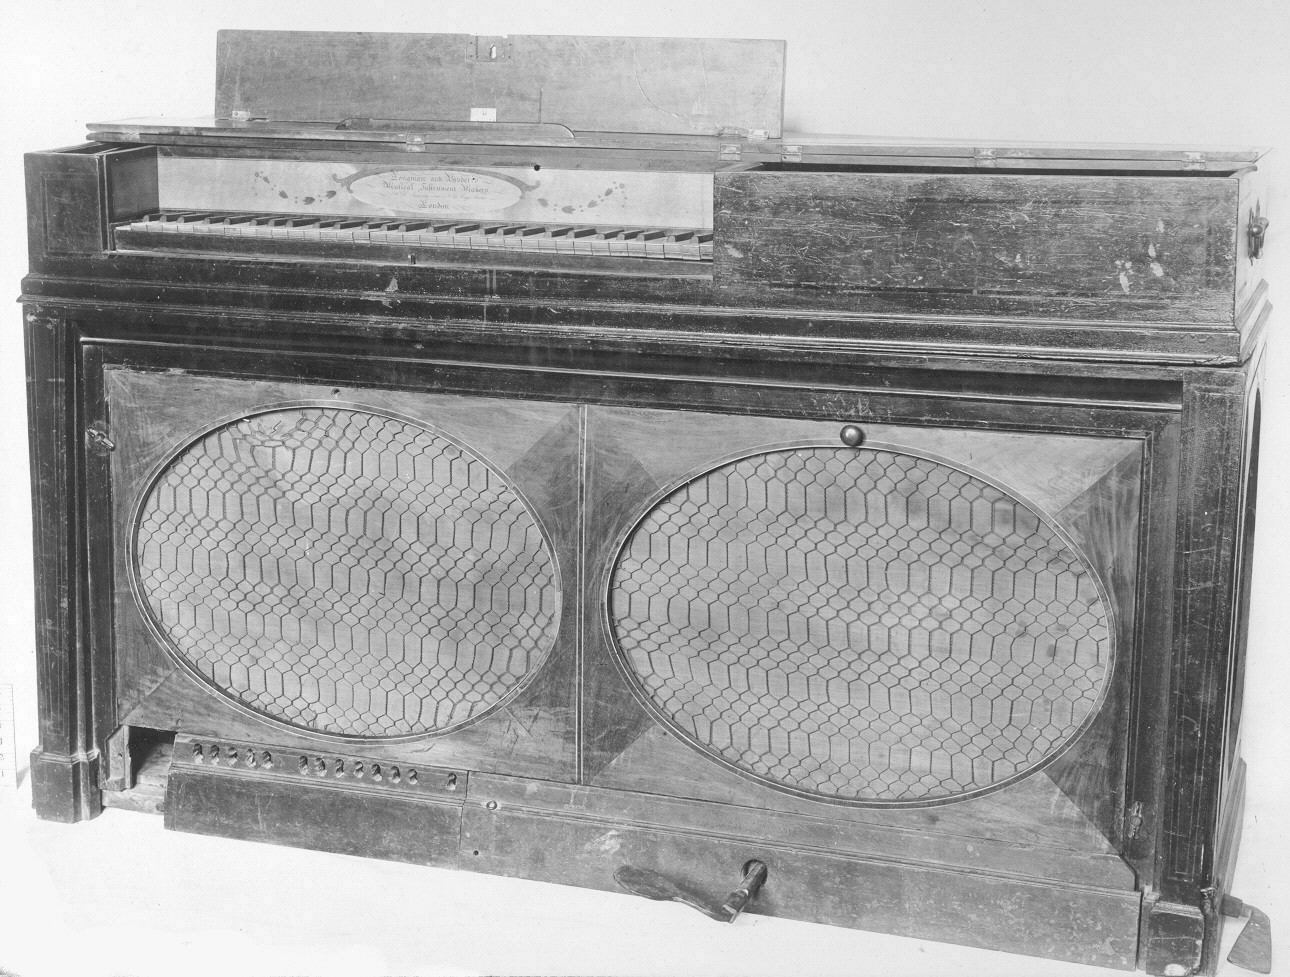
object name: organized square piano square piano and pipe organ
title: Organized square piano (square piano and pipe organ)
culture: british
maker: longman & broderip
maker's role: maker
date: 1786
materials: wood, iron, ivory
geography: united kingdom